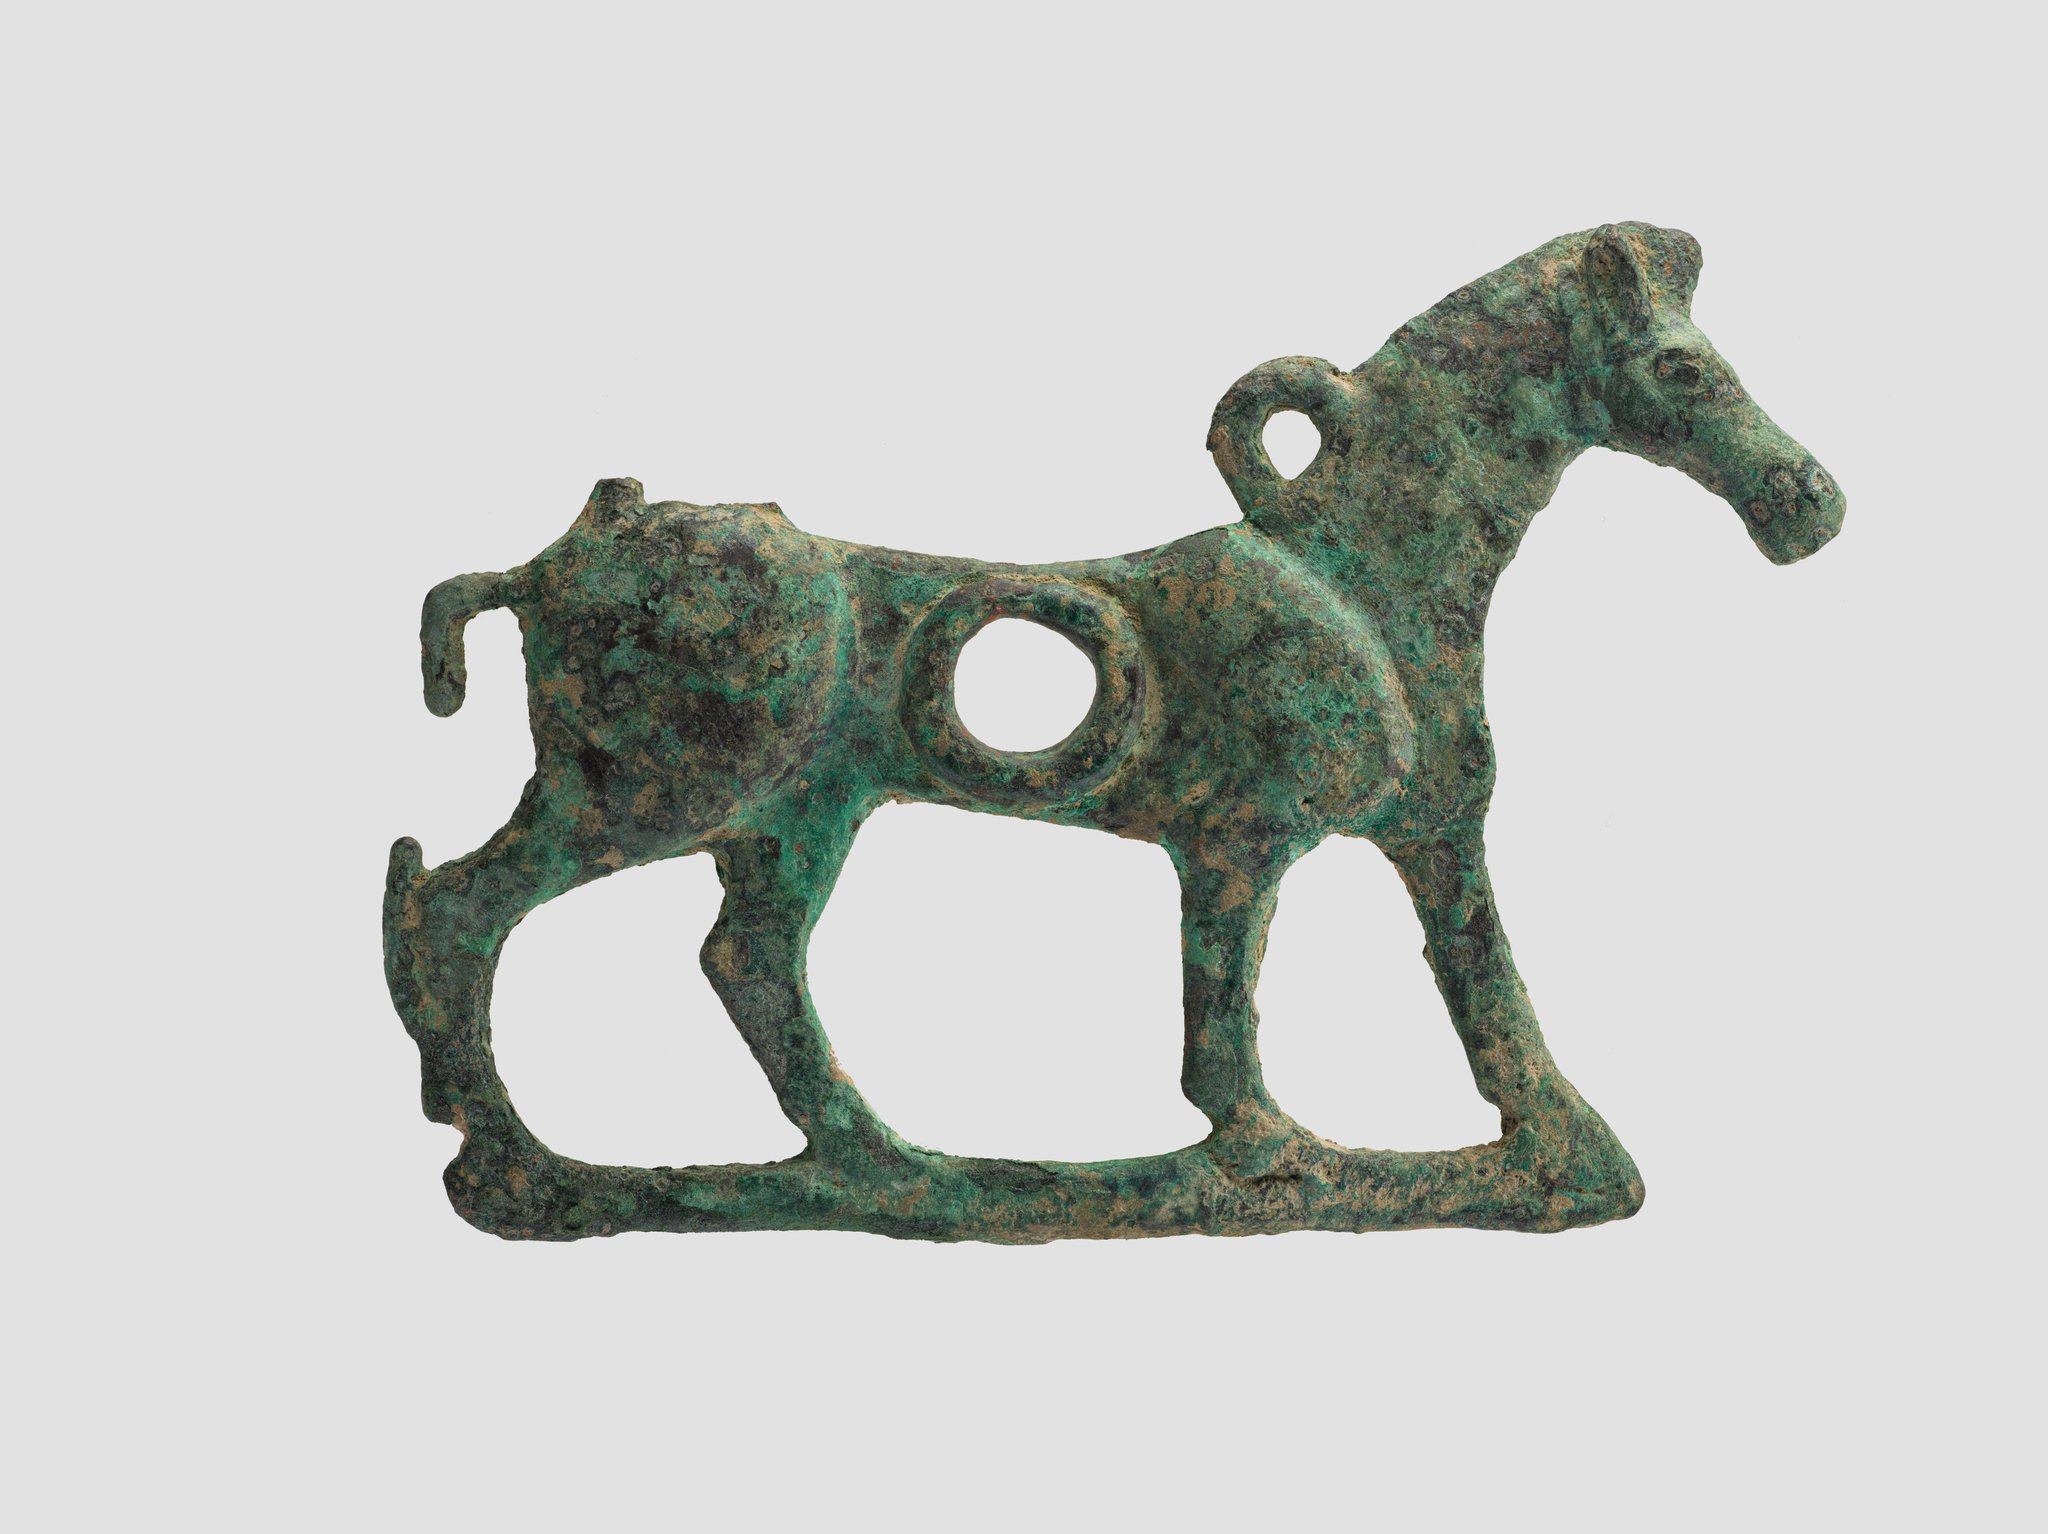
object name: horse bit cheekpiece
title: Horse bit cheekpiece in form of a striding horse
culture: iranian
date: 800-601 BCE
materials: bronze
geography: iran, probably from luristan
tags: horses